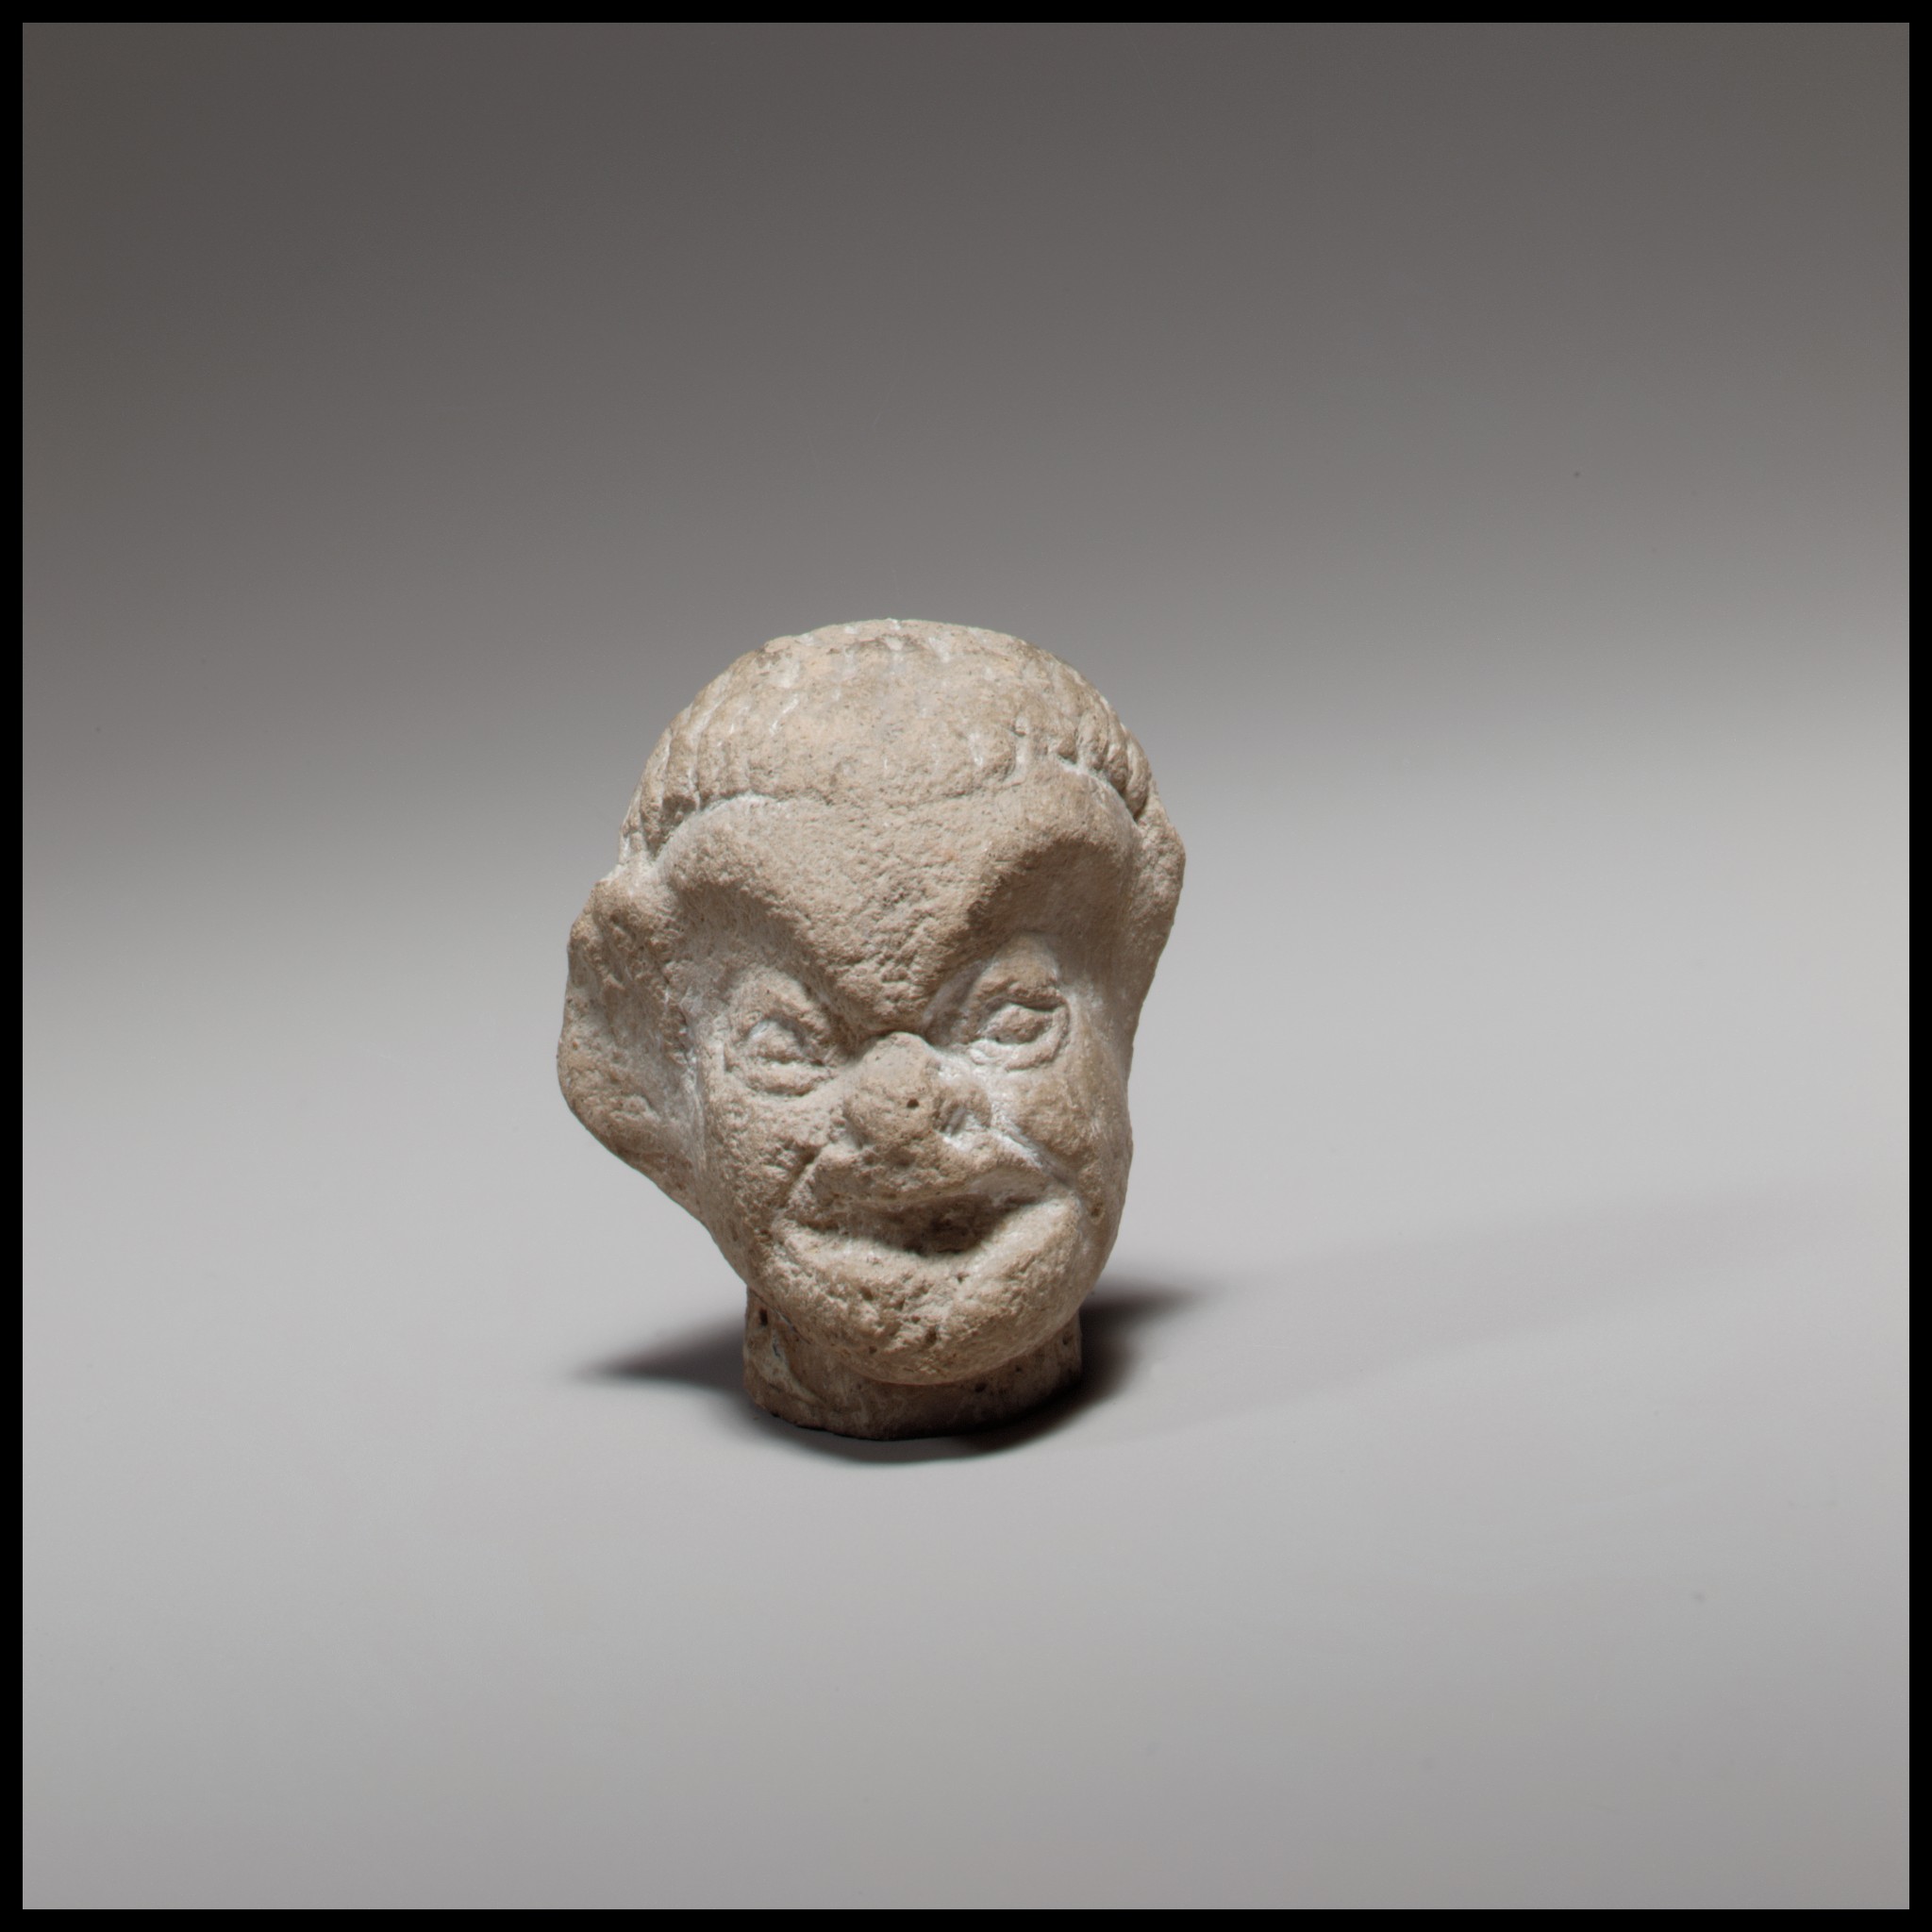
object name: head of a figurine, comic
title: Head of a comic figurine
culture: cypriot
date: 500-301 BCE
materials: terracotta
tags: heads